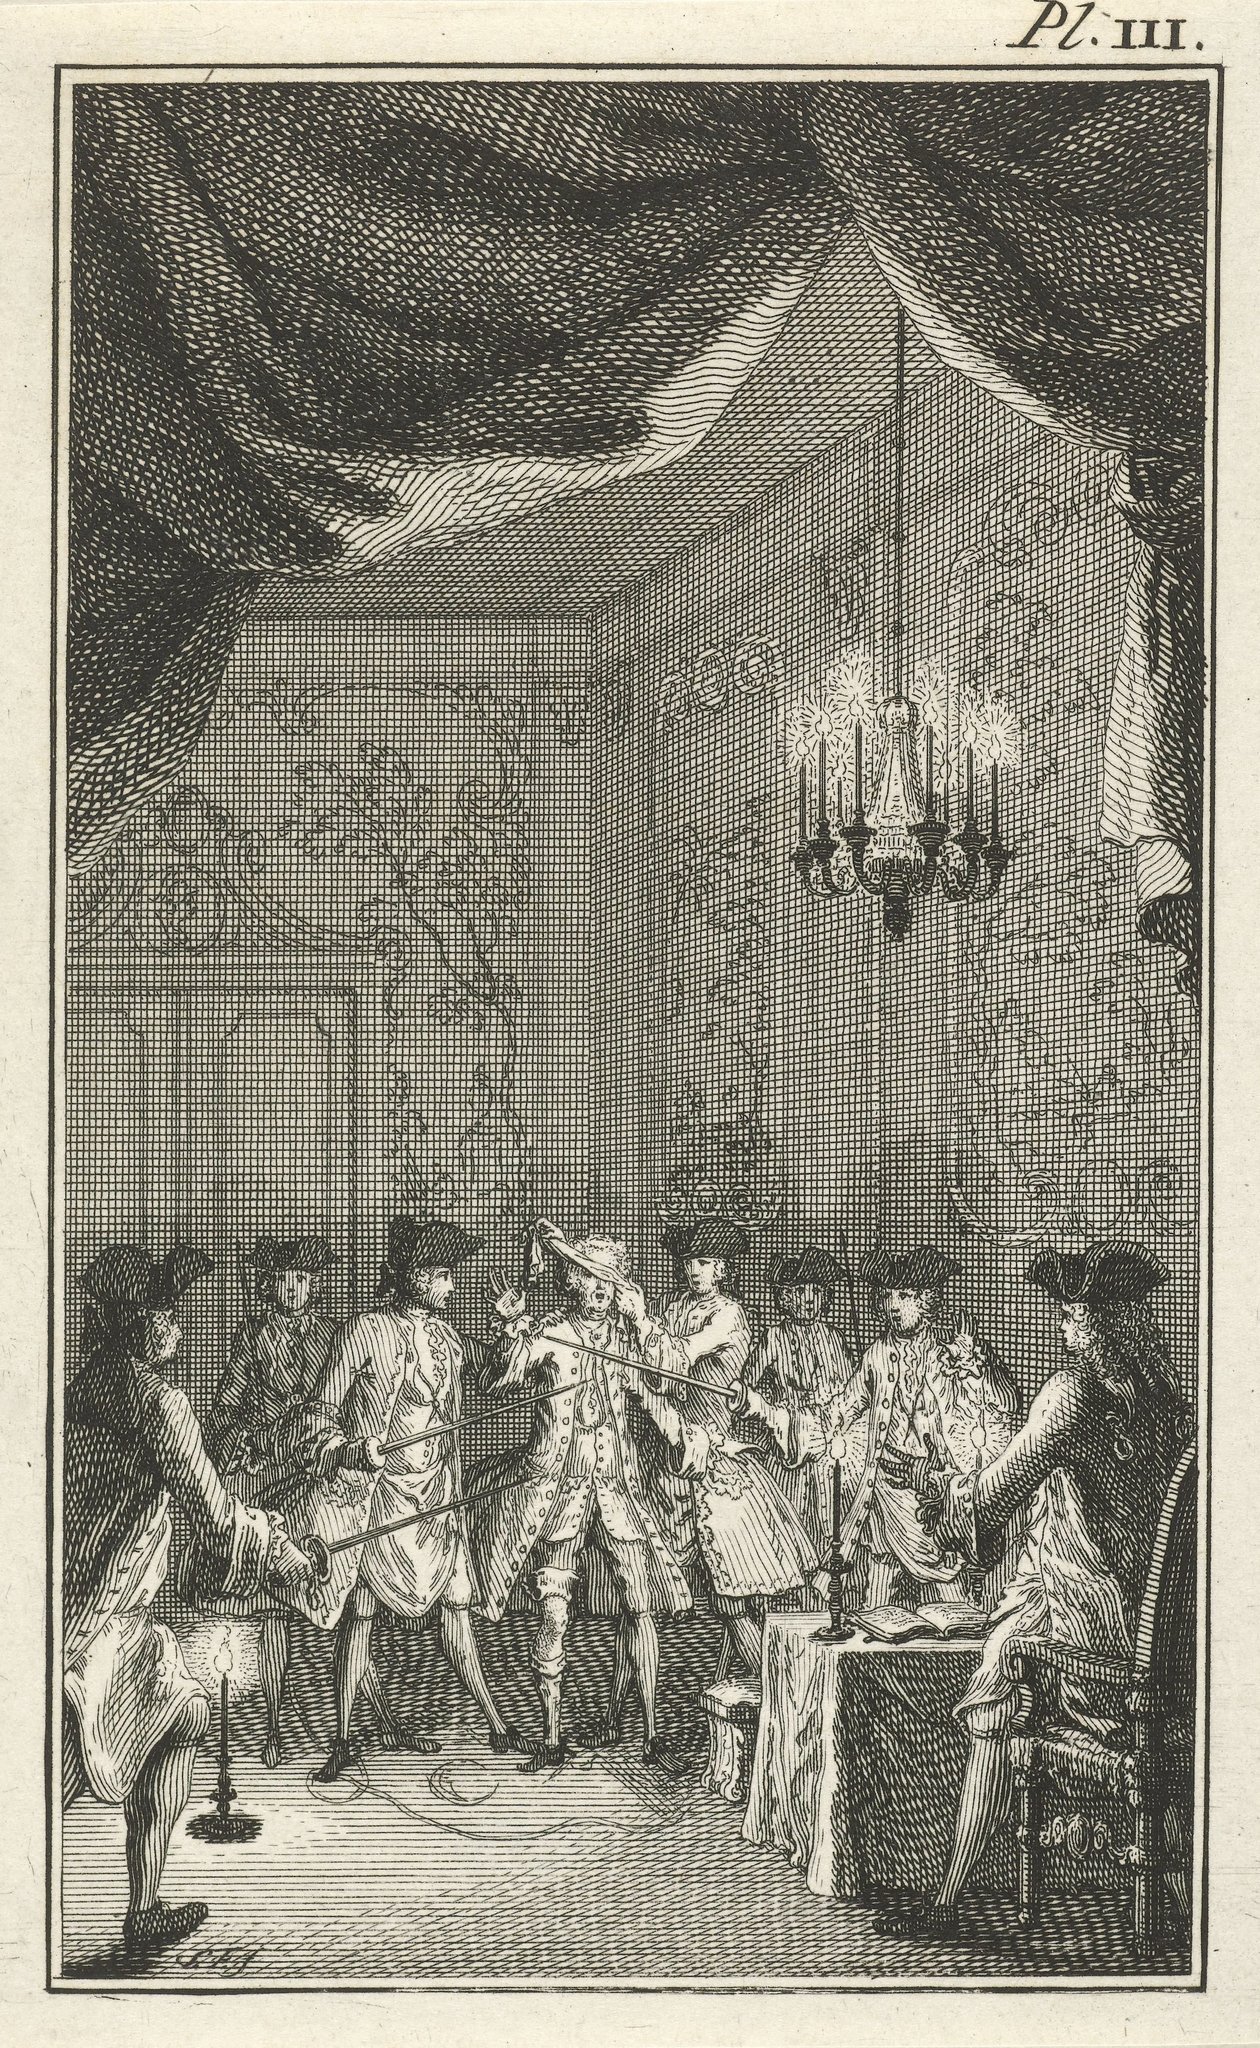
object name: book illustration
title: Gewapende heren in een vertrek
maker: simon fokke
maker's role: draughtsman, print maker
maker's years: 1712-1784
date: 1722-1784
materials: paper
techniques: engraving, etching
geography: amsterdam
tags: hacking and thrusting weapons: rapier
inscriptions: collector's mark: Lugt 240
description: In een vertrek staat een groep heren met geheven degen rond een man met blinddoek. Rechts is een man achter een tafel opgestaan uit zijn stoel. Prent rechtsboven gemerkt: Pl. III.